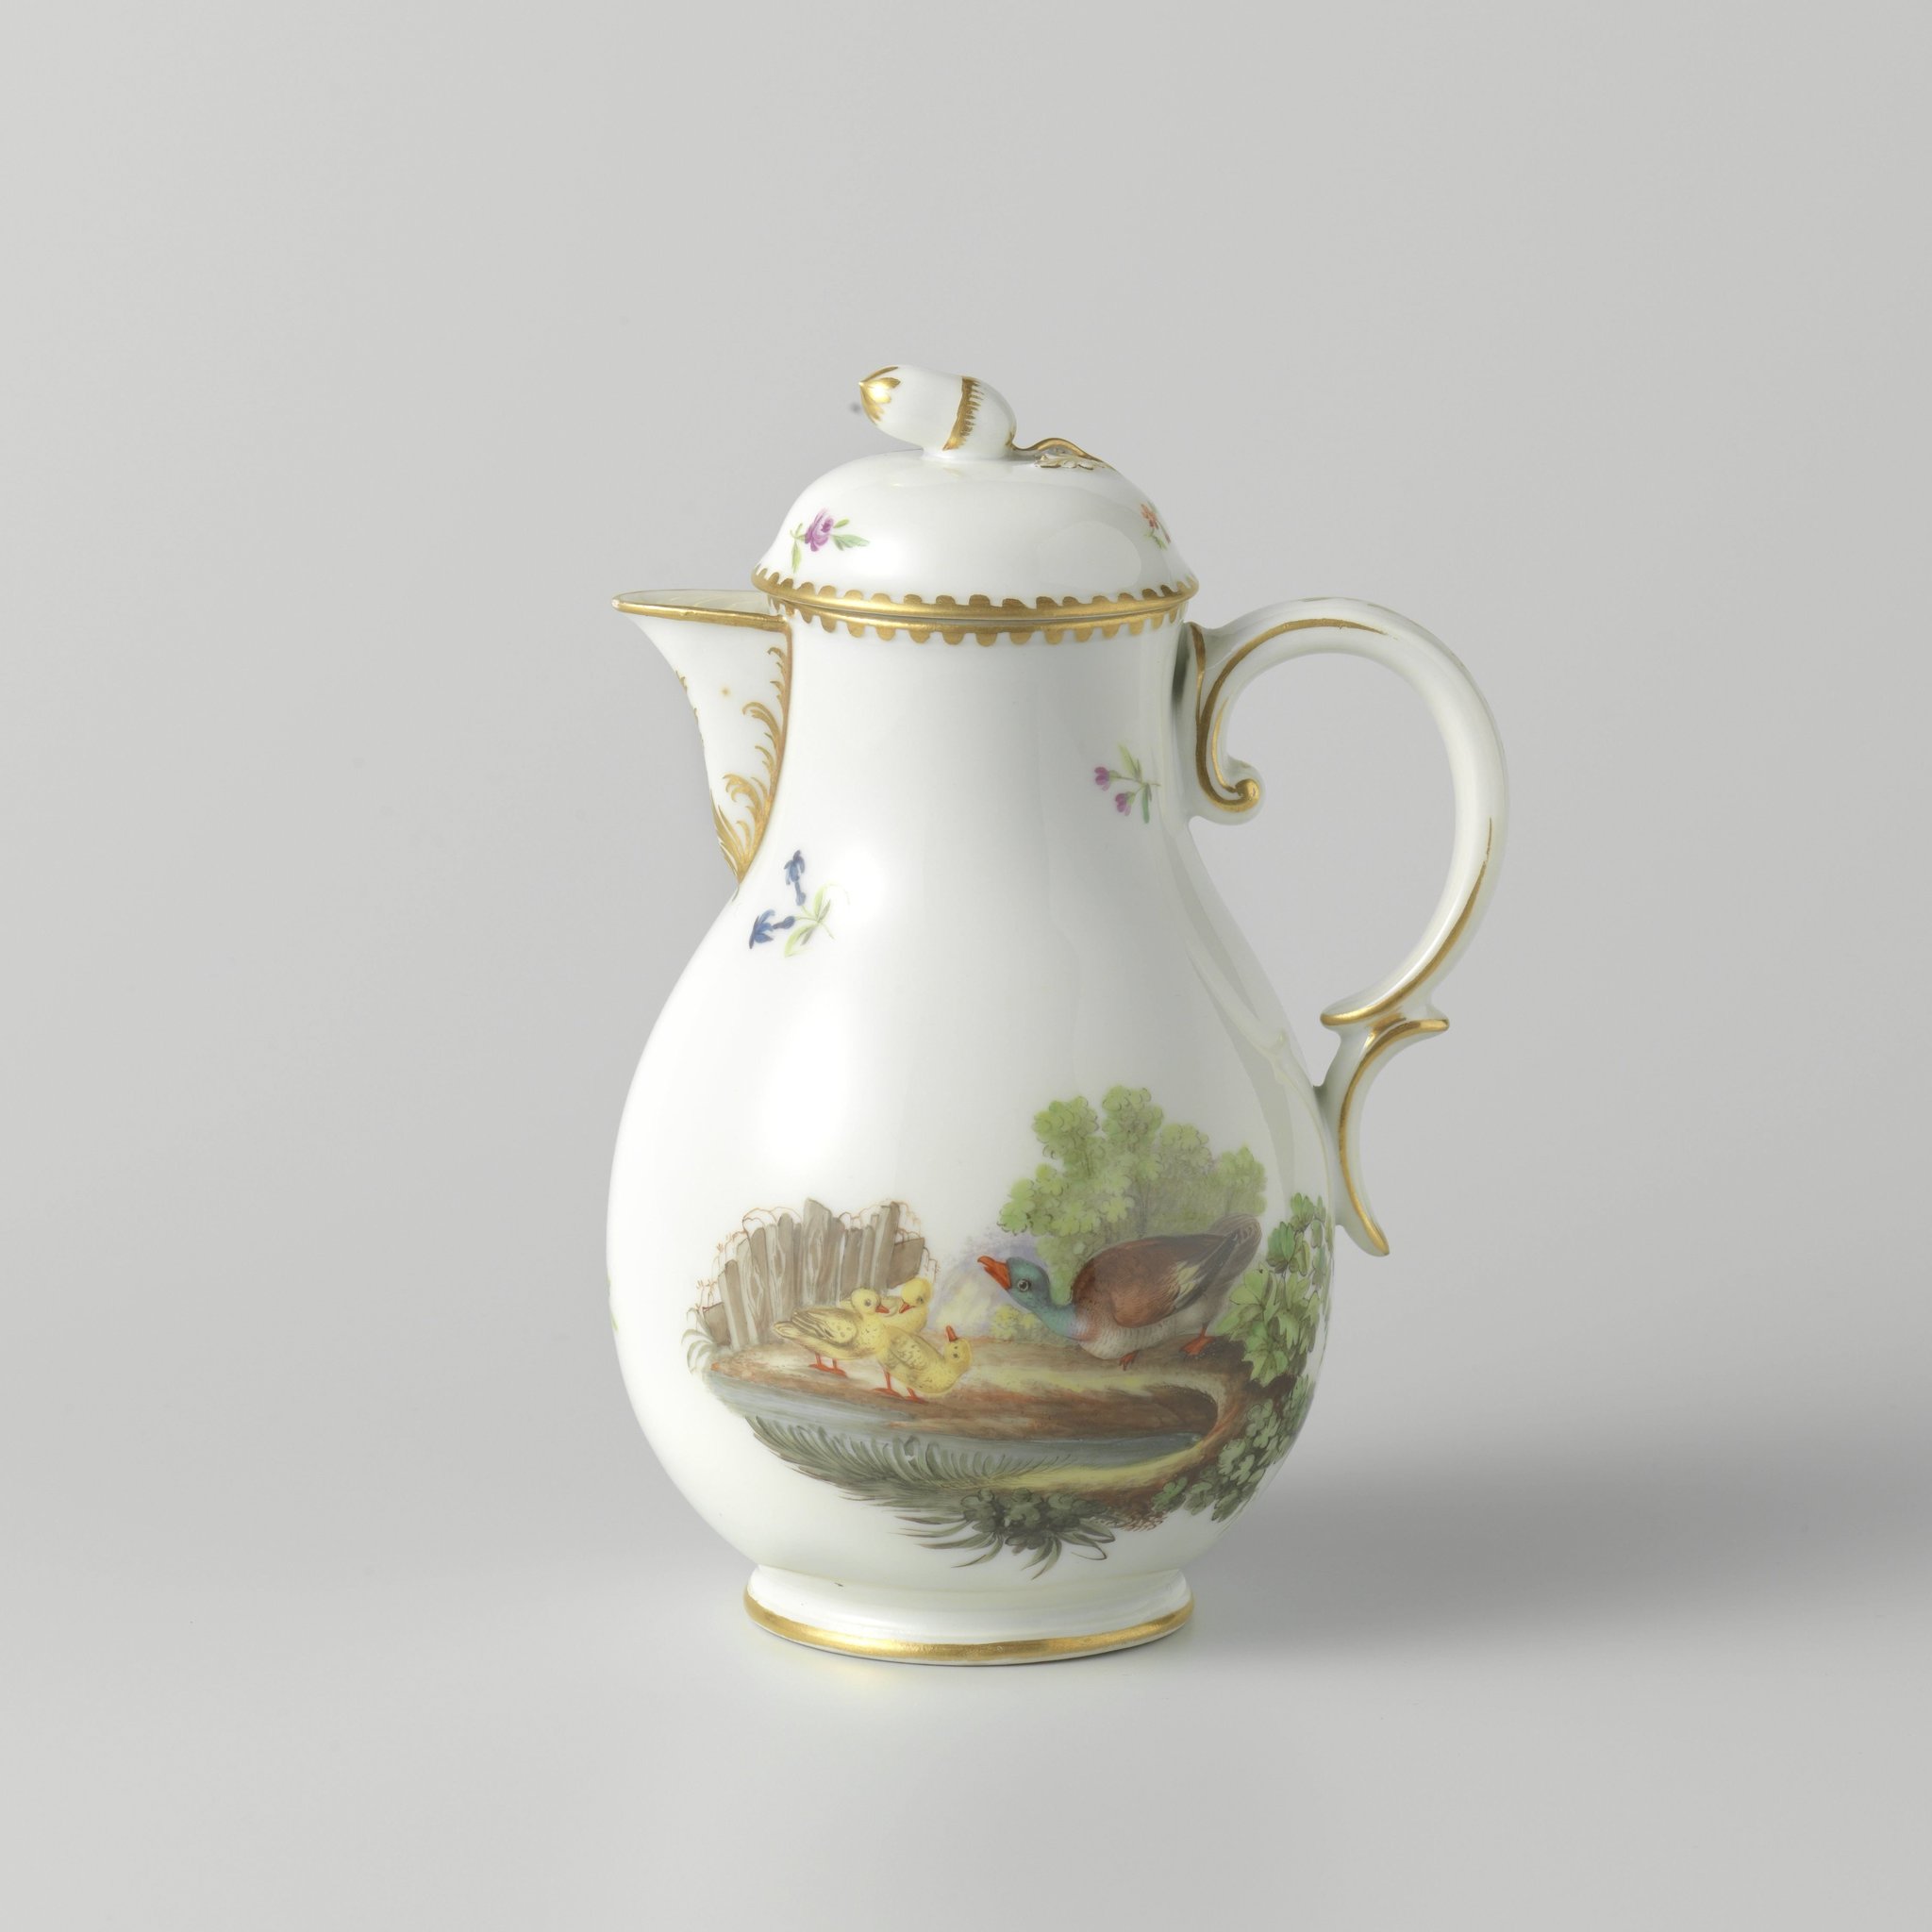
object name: milk jug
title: Part of a tea service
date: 1782-1784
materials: porcelain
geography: loosdrecht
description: Manufactuur Oud-Loosdrecht Loosdrecht, c. 1782–1784 hard-paste porcelain